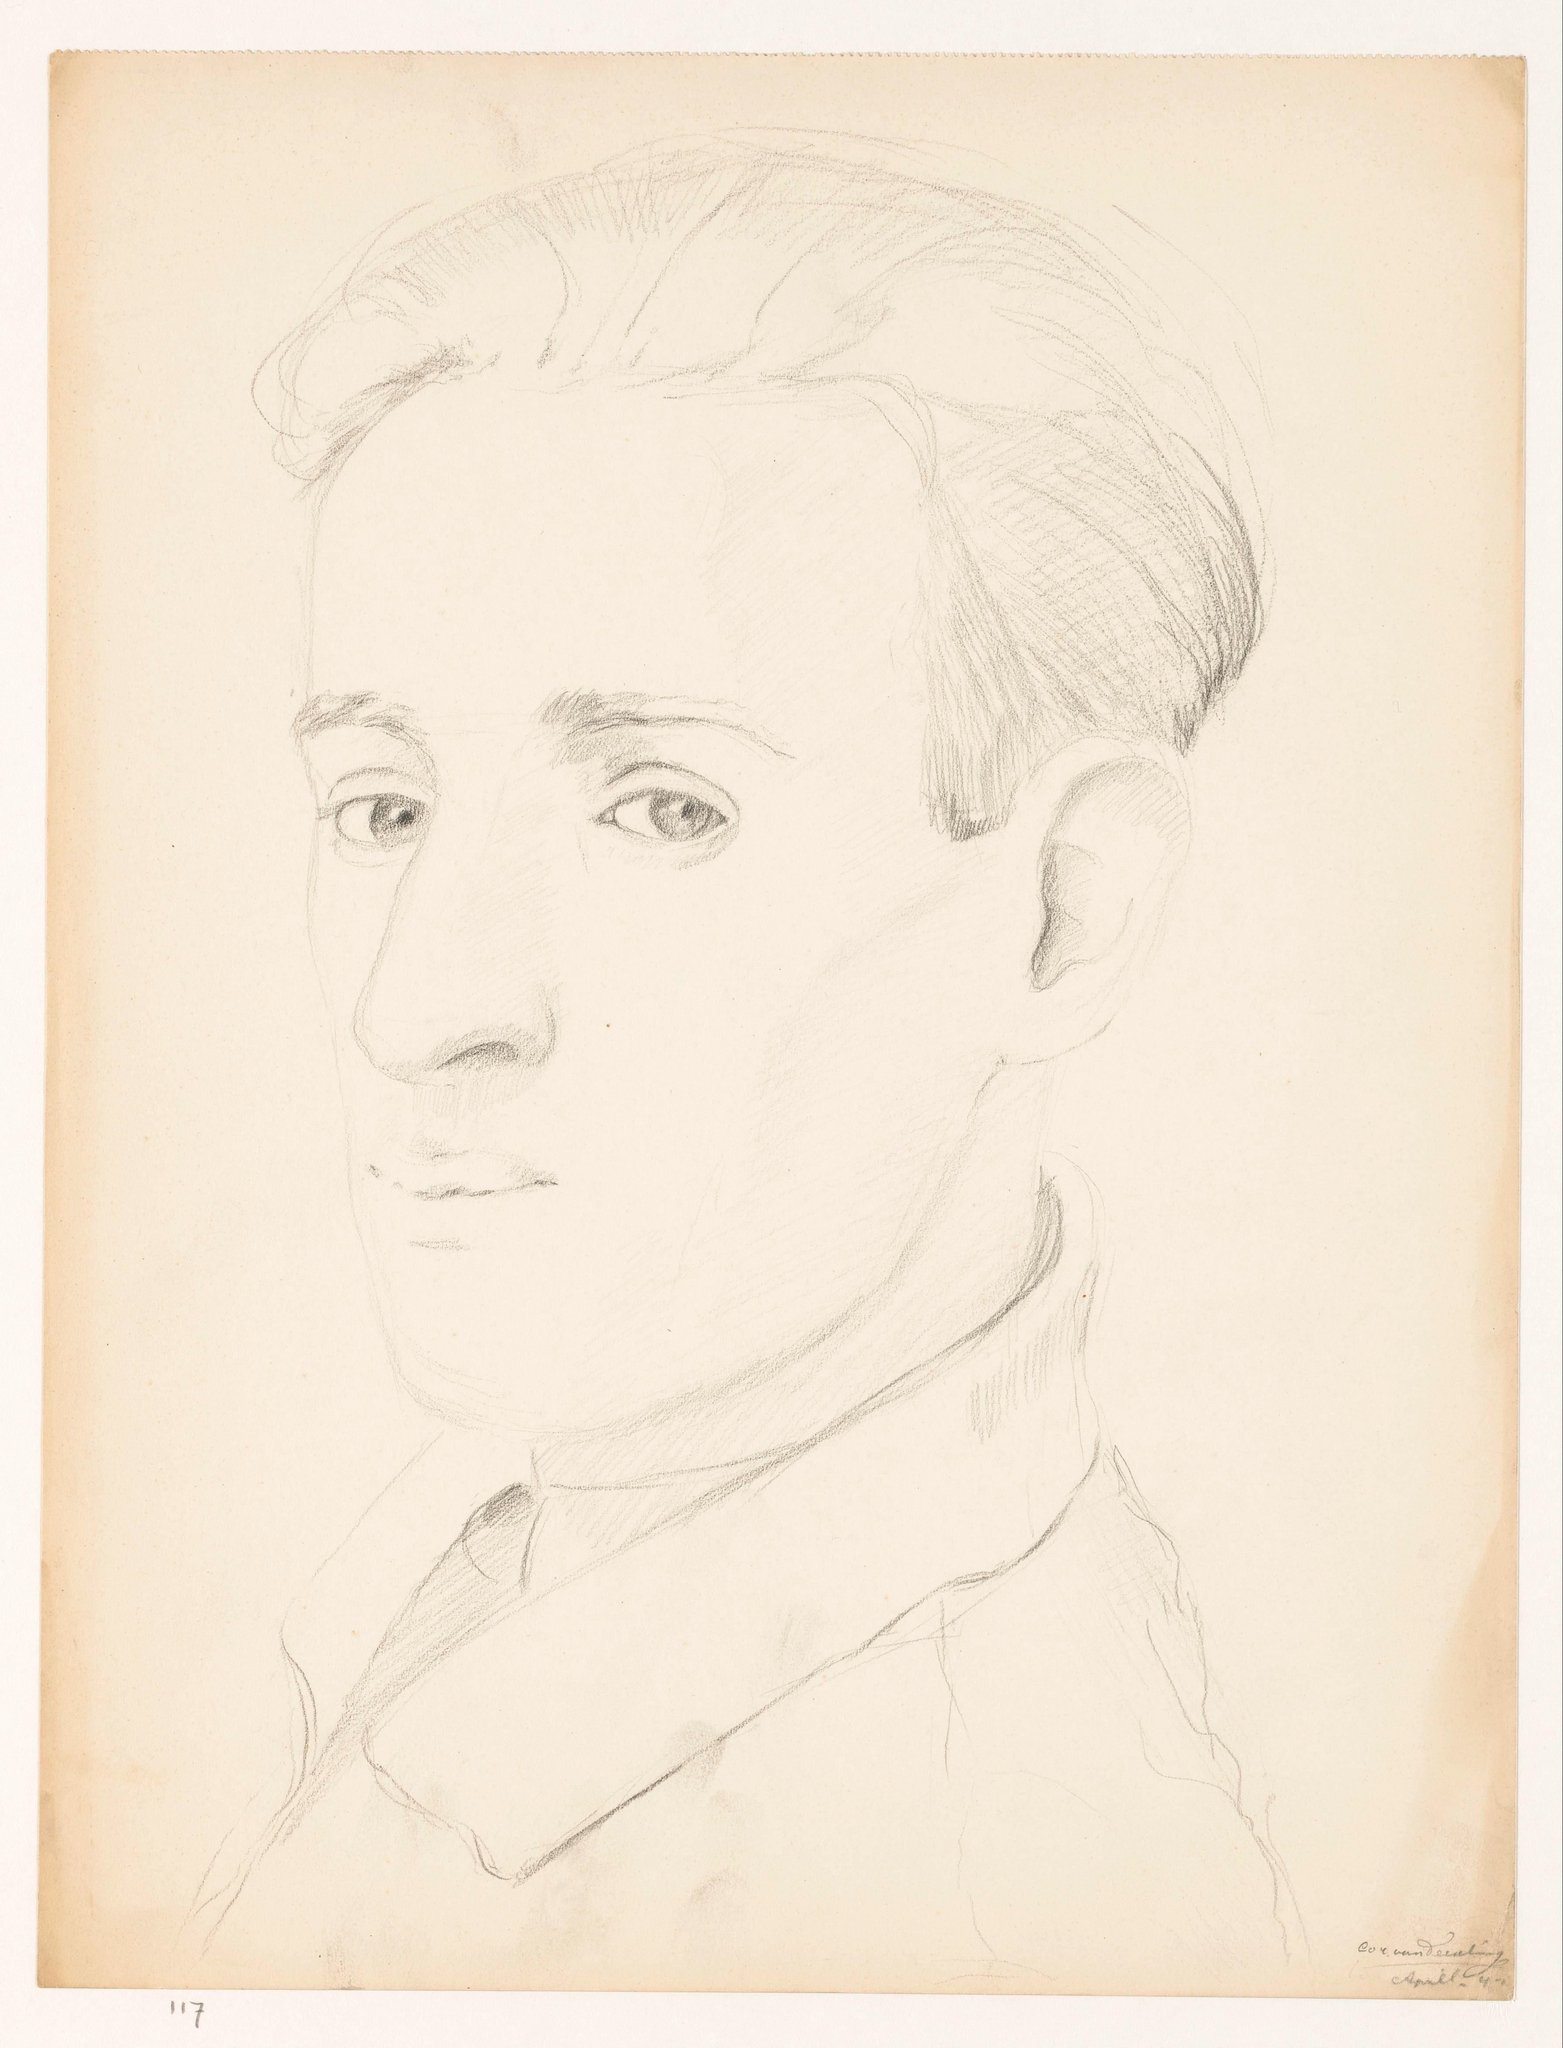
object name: drawing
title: Zelfportret, april 1942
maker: cor van teeseling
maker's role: draughtsman, sculptor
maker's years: 1915-1942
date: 1904-1942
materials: paper, pencil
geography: amsterdam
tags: amsterdam, sculptor, cor van teeseling, historical persons, prisoner in cell or locked place, portrait, self-portrait of draughtsman, netherlands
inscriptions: date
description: Zelfportret van Cor van Teeseling, april 1942. Cor van Teeseling driekwart afgebeeld, zijn hoofd naar links gewend.